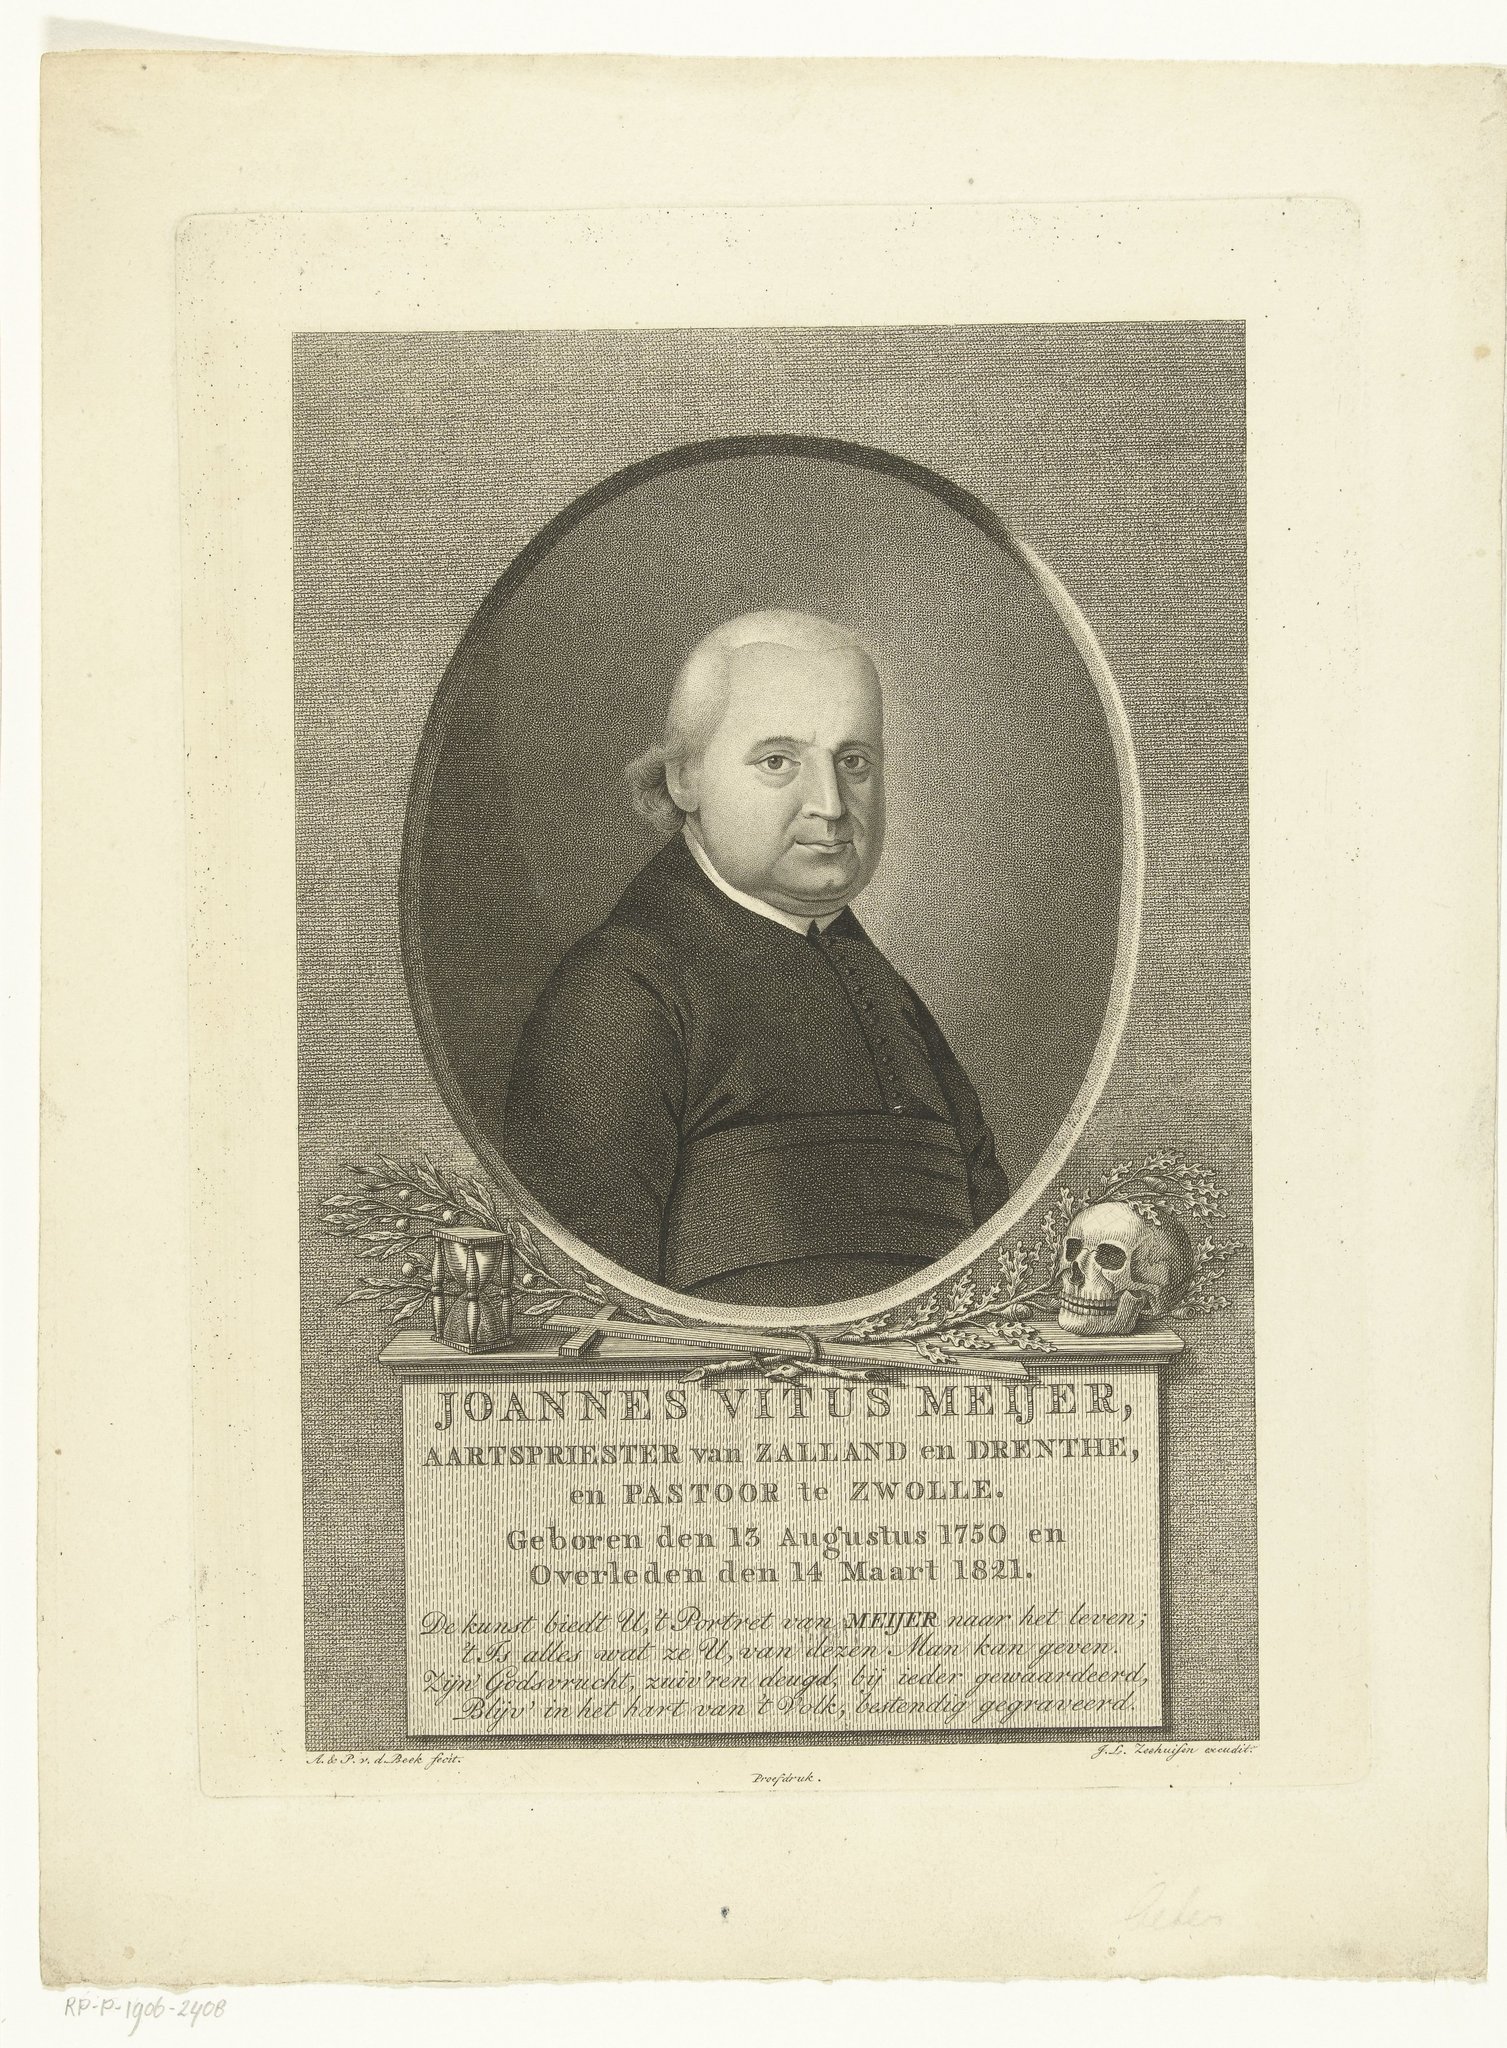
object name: print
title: Portret van aartspriester Johannes Vitus Meijer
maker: joh. louis zeehuisen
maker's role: publisher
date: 1821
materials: paper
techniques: aquatint, etching, roulette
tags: skull as symbol of 'vanitas', hourglass, chief priests ~ hierarchy of priests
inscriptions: collector's mark: Lugt 2228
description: Buste van aartspriester Johannes Vitus Meijer in ovale omlijsting met onder het portret vanitas symbolen zoals een doodshoofd en zandloper. Onder de de naam en titel van de man staat een lofdicht.